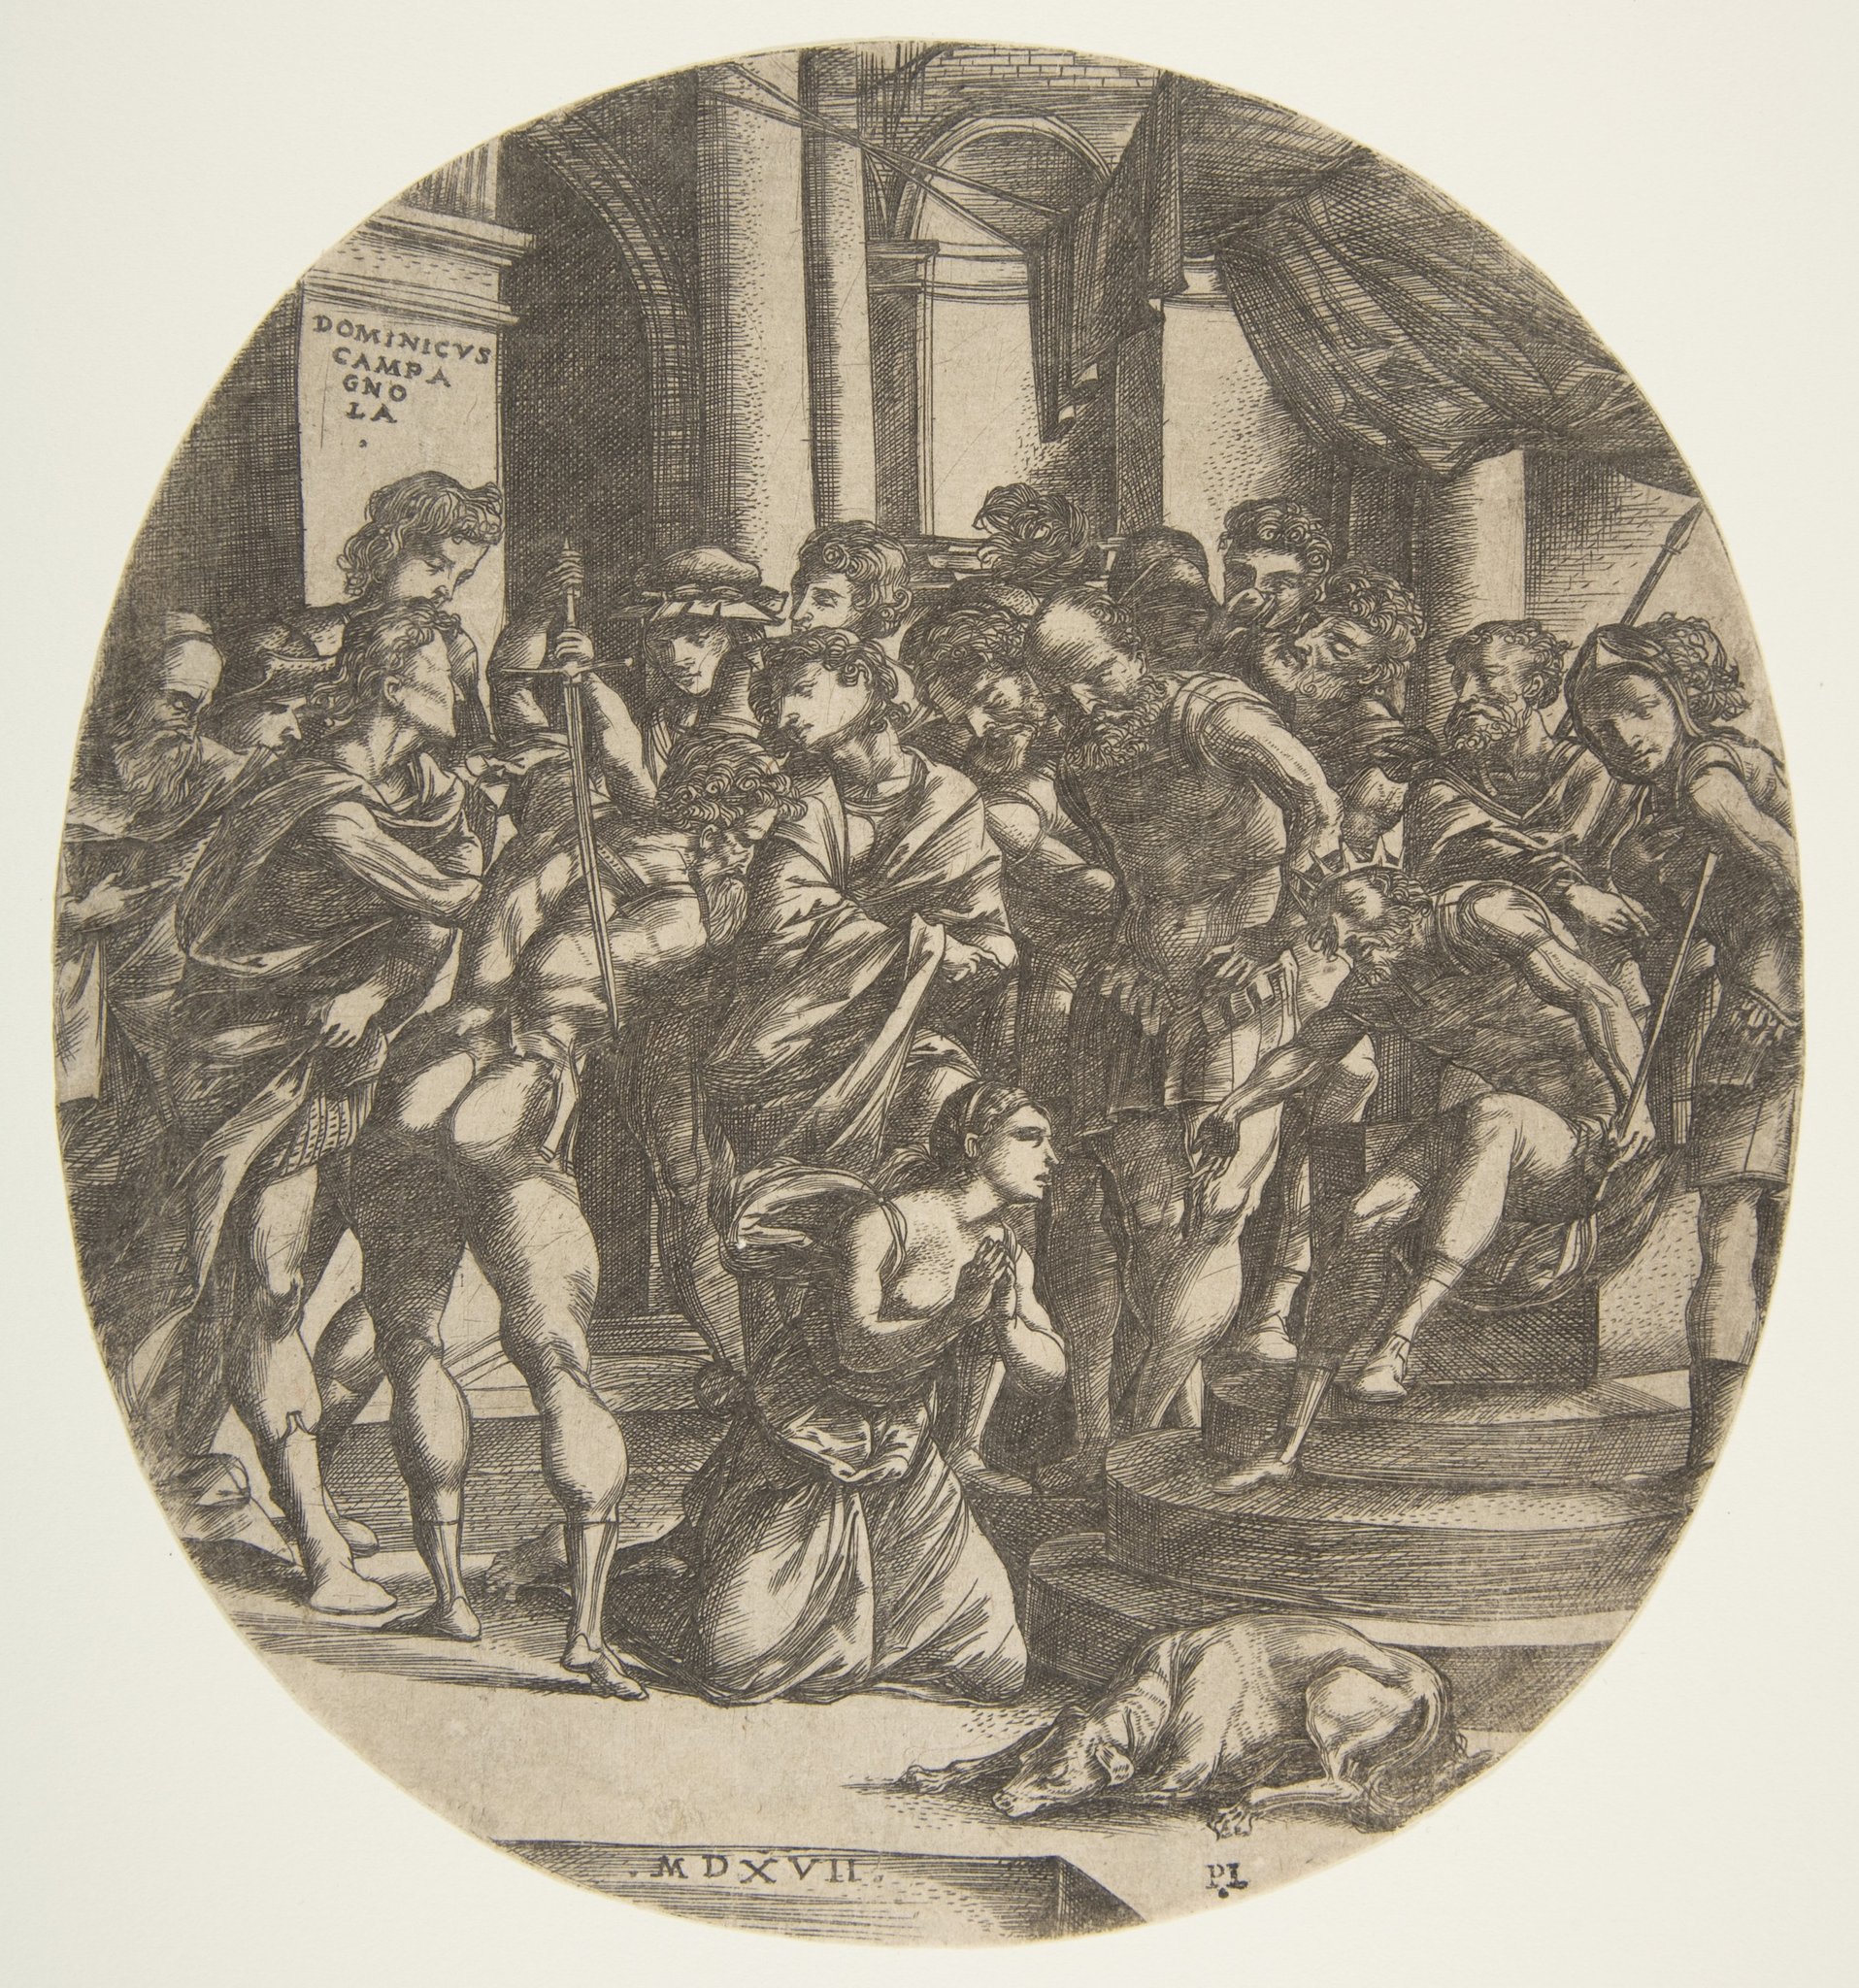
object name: print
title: Female figure (Saint Catherine?) kneeling on the ground at center pleading to a male figure (Maximus?) who wears a crown and is seated on a throne at right; at left a figure with raised sword about to strike the woman; a group of figures looking on in the background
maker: domenico campagnola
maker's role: artist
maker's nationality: italian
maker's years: 1500-1564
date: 1517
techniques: engraving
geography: venice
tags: swords,saint catherine,crowd